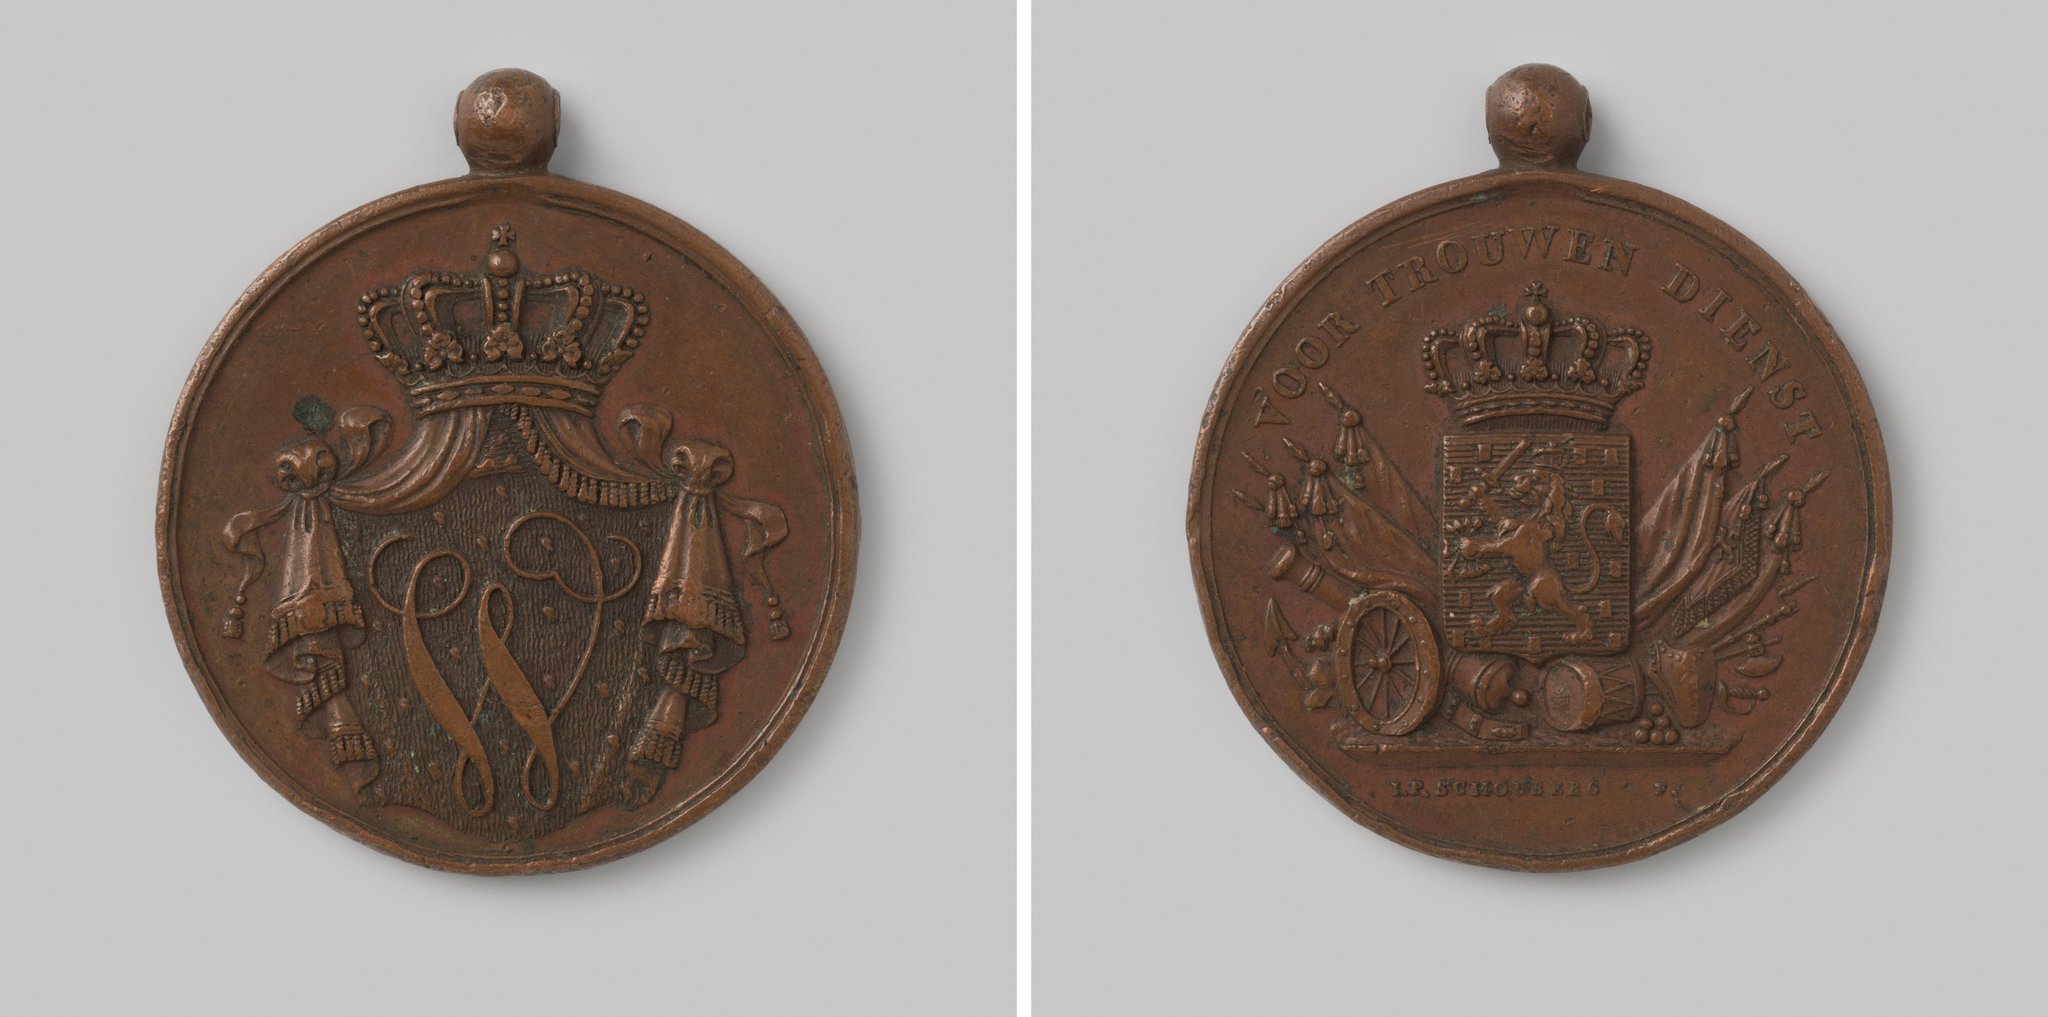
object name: history medal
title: Medaille voor trouwe dienst bij de landmacht (1825)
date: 1830-1861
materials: bronze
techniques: striking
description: Bronzen penning met bal zonder draagring, op de voorzijde sierletter W op gekroonde mantel, op de keerzijde het gekroonde Nederlandse wapenschild te midden van militaire attributen, met omschrift.